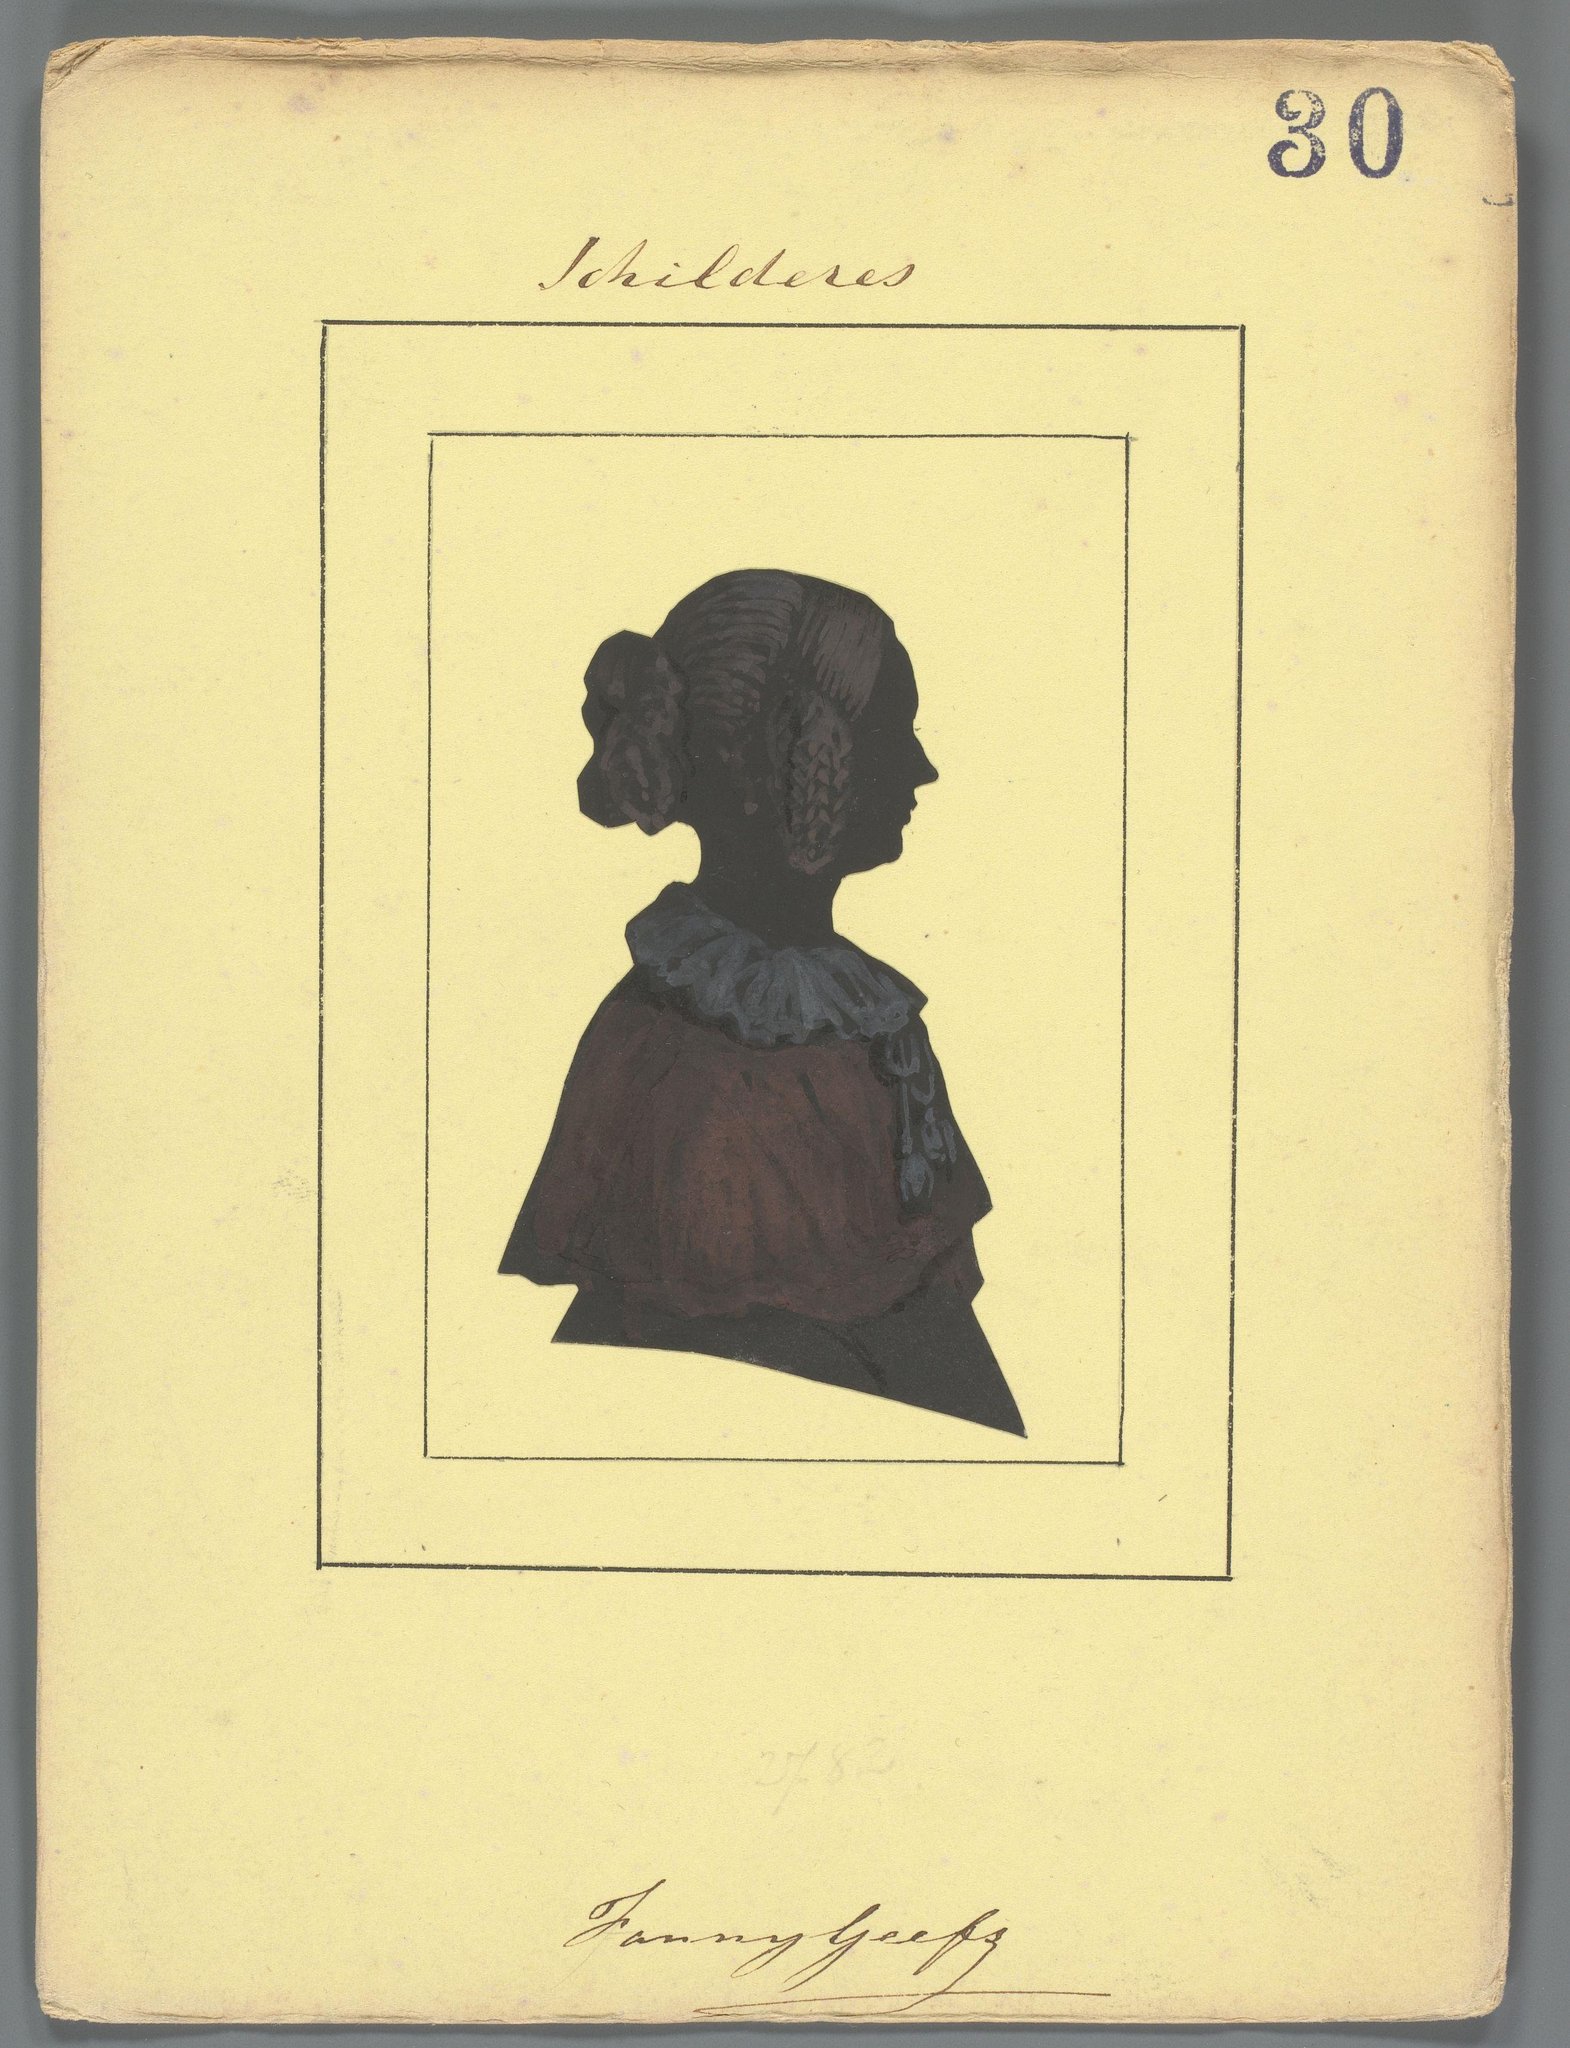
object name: drawing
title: Silhouetportret van Fanny Geefs-Corr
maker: elisabeth alida haanen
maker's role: draughtsman, print maker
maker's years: 1809-1845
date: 1819-1845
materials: ink, paint, paper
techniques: brush, snipping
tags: brussels, painter, print maker, draughtsman, fanny geefs-corr, historical persons - bb - woman, portrait, self-portrait of painter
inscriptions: number: ‘30’, collector's mark: ‘Ex-libris van Beresteyn’, number: ‘13968’, inscription: ‘Schilderes’, inscription: ‘Neg. D. 1733’, inscription: ‘Fanny Geefs’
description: Met onder het portret de handtekening van de geportretteerde.